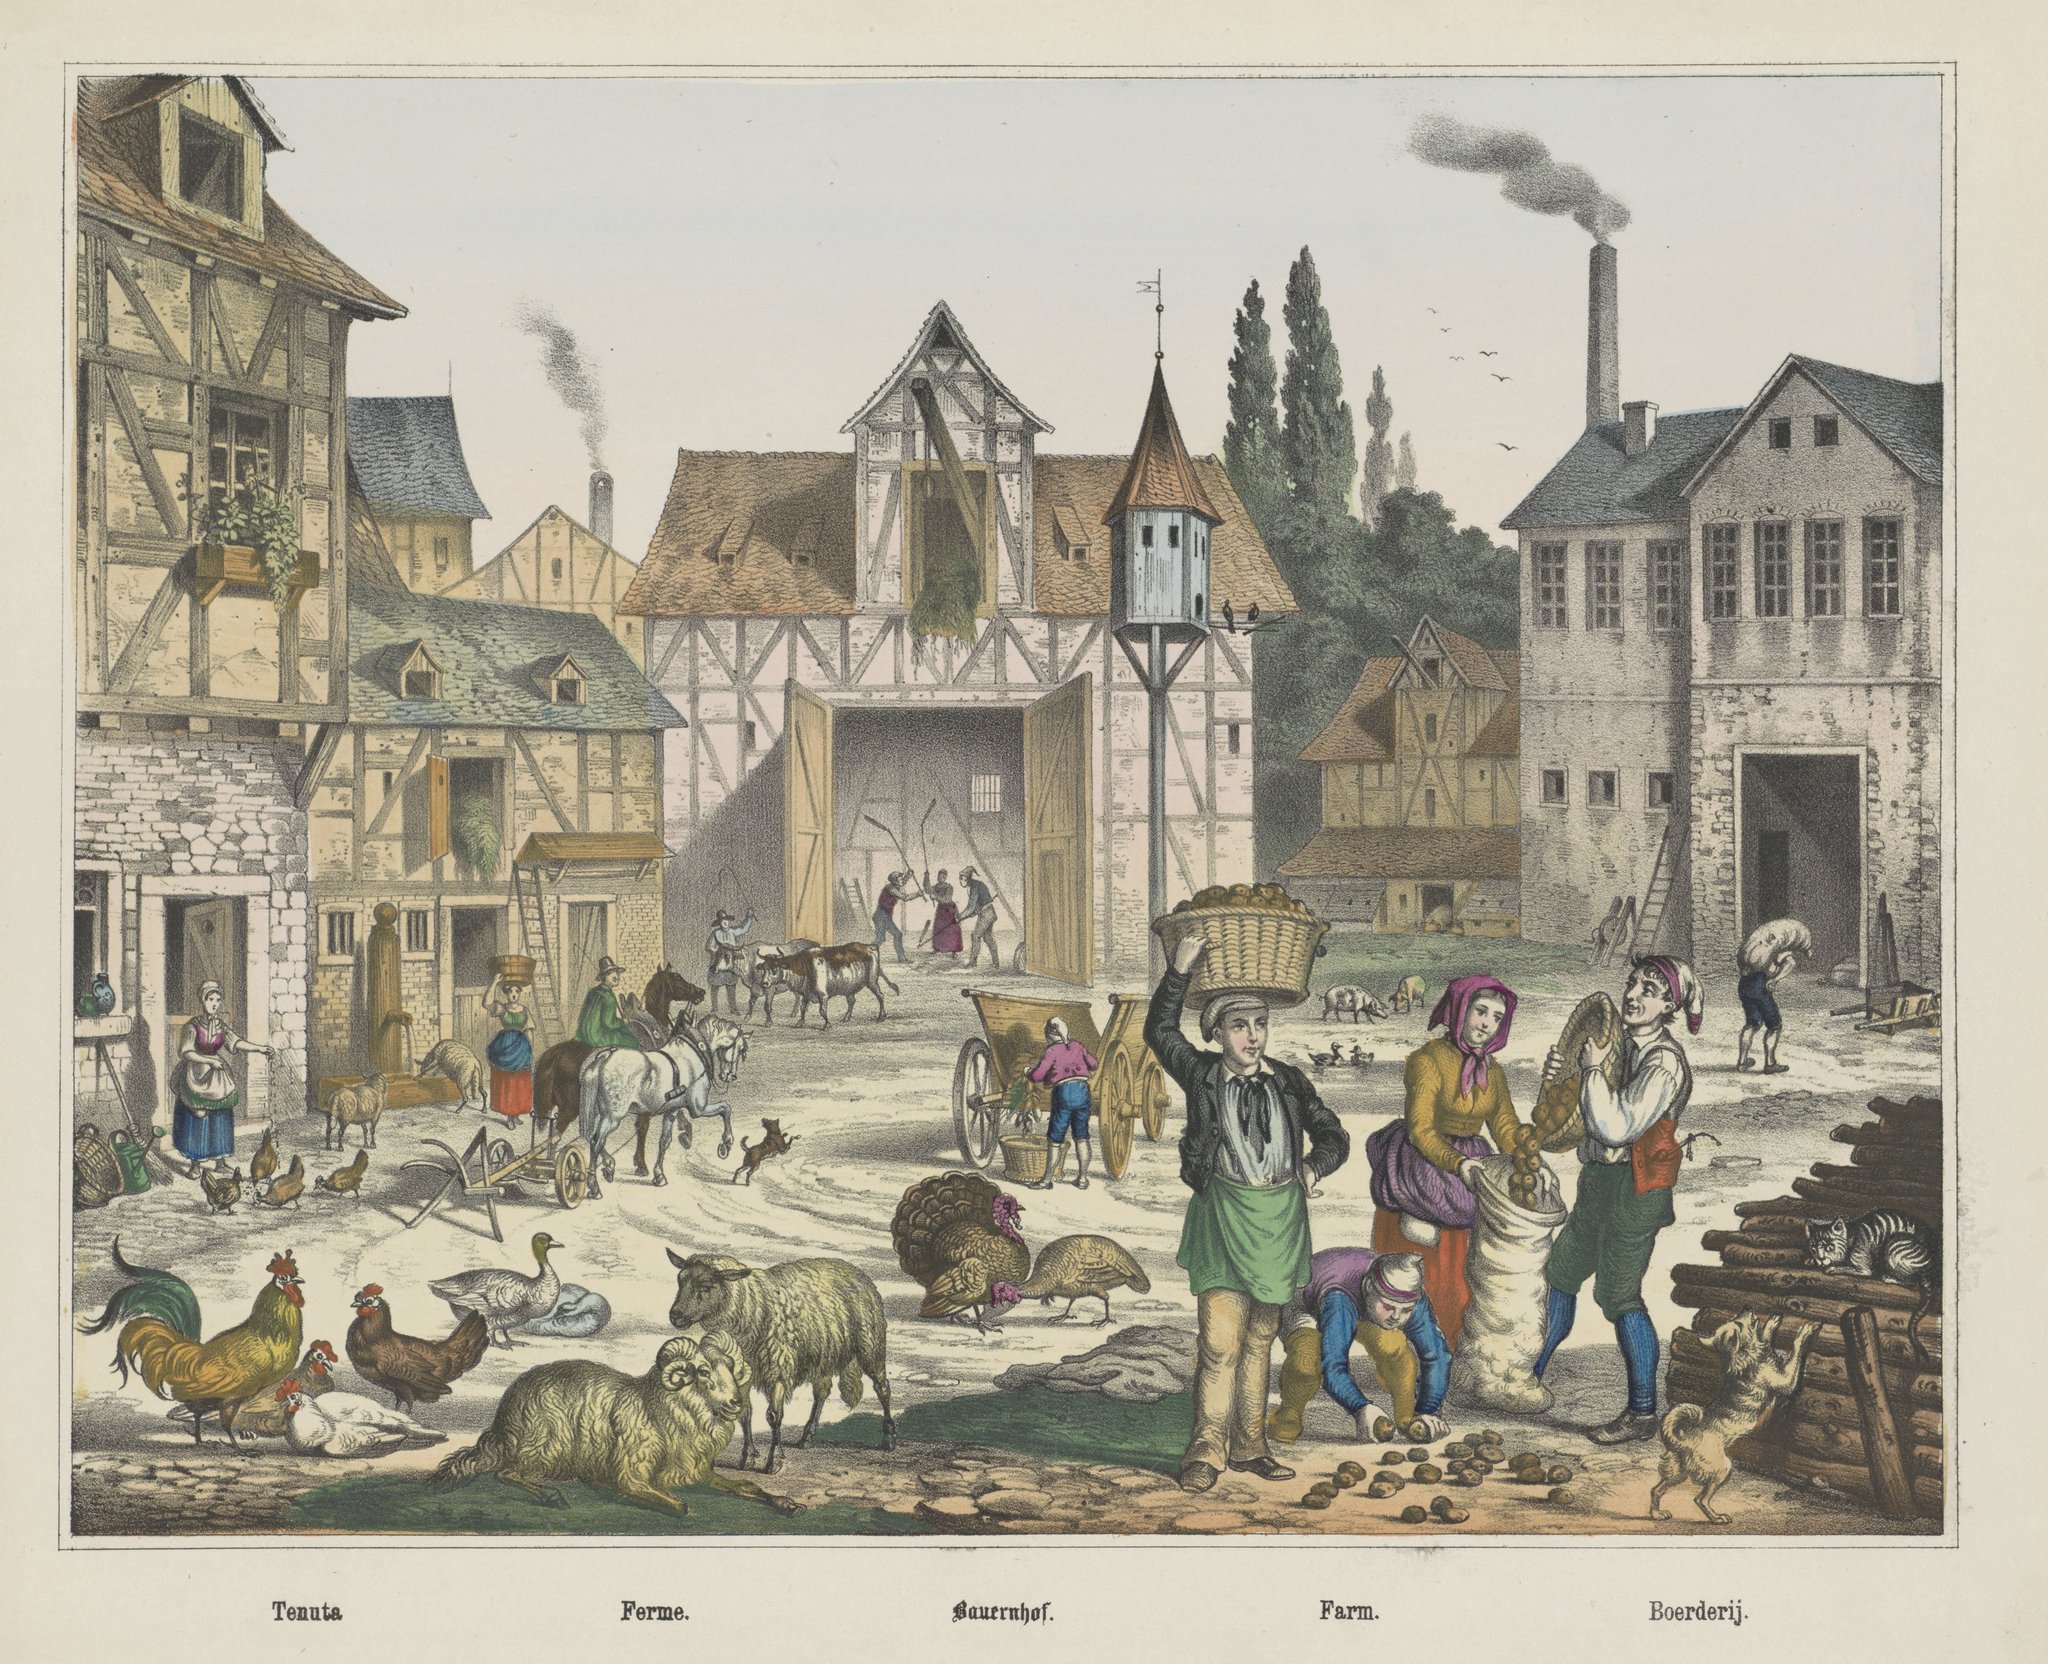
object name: popular print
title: Tenuta. / Ferme. / Bauernhof. / Farm. / Boerderij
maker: Anonymous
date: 1829-1880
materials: paper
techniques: colour, lithograph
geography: mainz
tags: pig, animals, farmers, farmers - aa - female farmer, farmer's wife, fowl (cock, hen, chicken, etc.), storing in sacks ~ harvest, farm (building), dog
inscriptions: collector's mark: Lugt 2760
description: Zicht op een erf van een boerderij waar verschillende boeren en boerinnen aan het werk zijn en boerderij dieren los lopen, waaronder kippen, schapen, kalkoenen, varkens, eenden een hond en een kat.